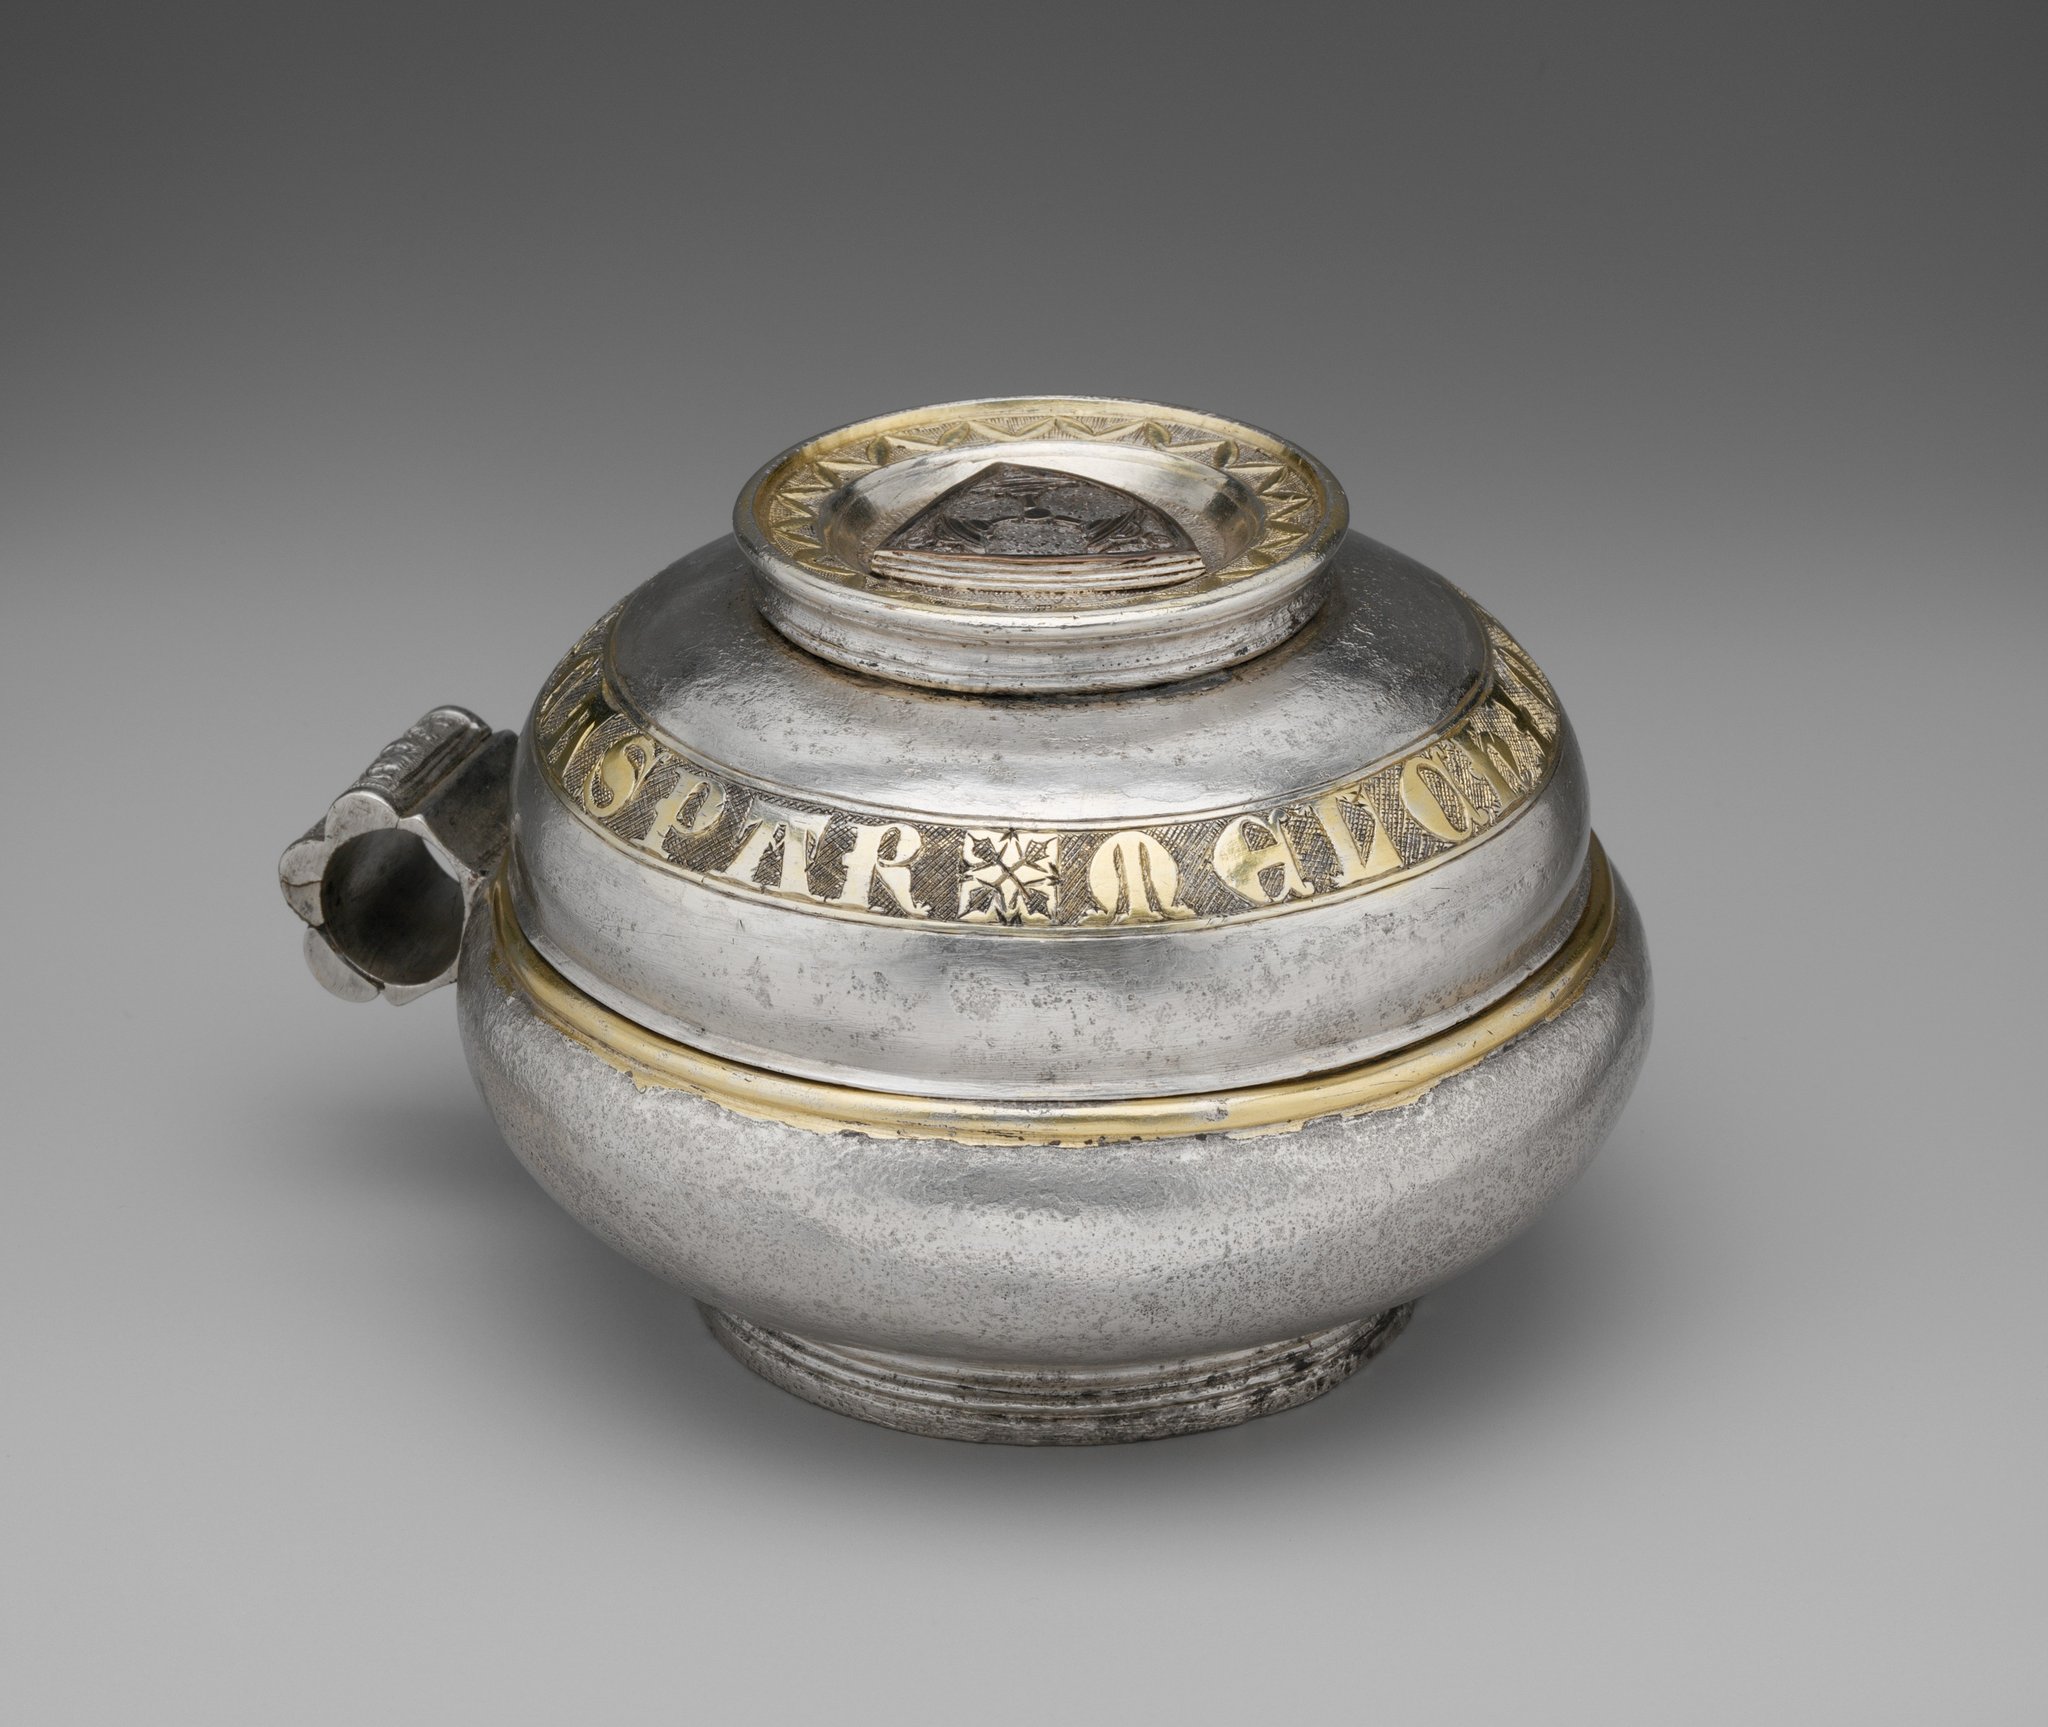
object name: cup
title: Double Cup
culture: german or bohemian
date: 1325-1350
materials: enamel, gilt silver, silver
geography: possibly prague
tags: coat of arms